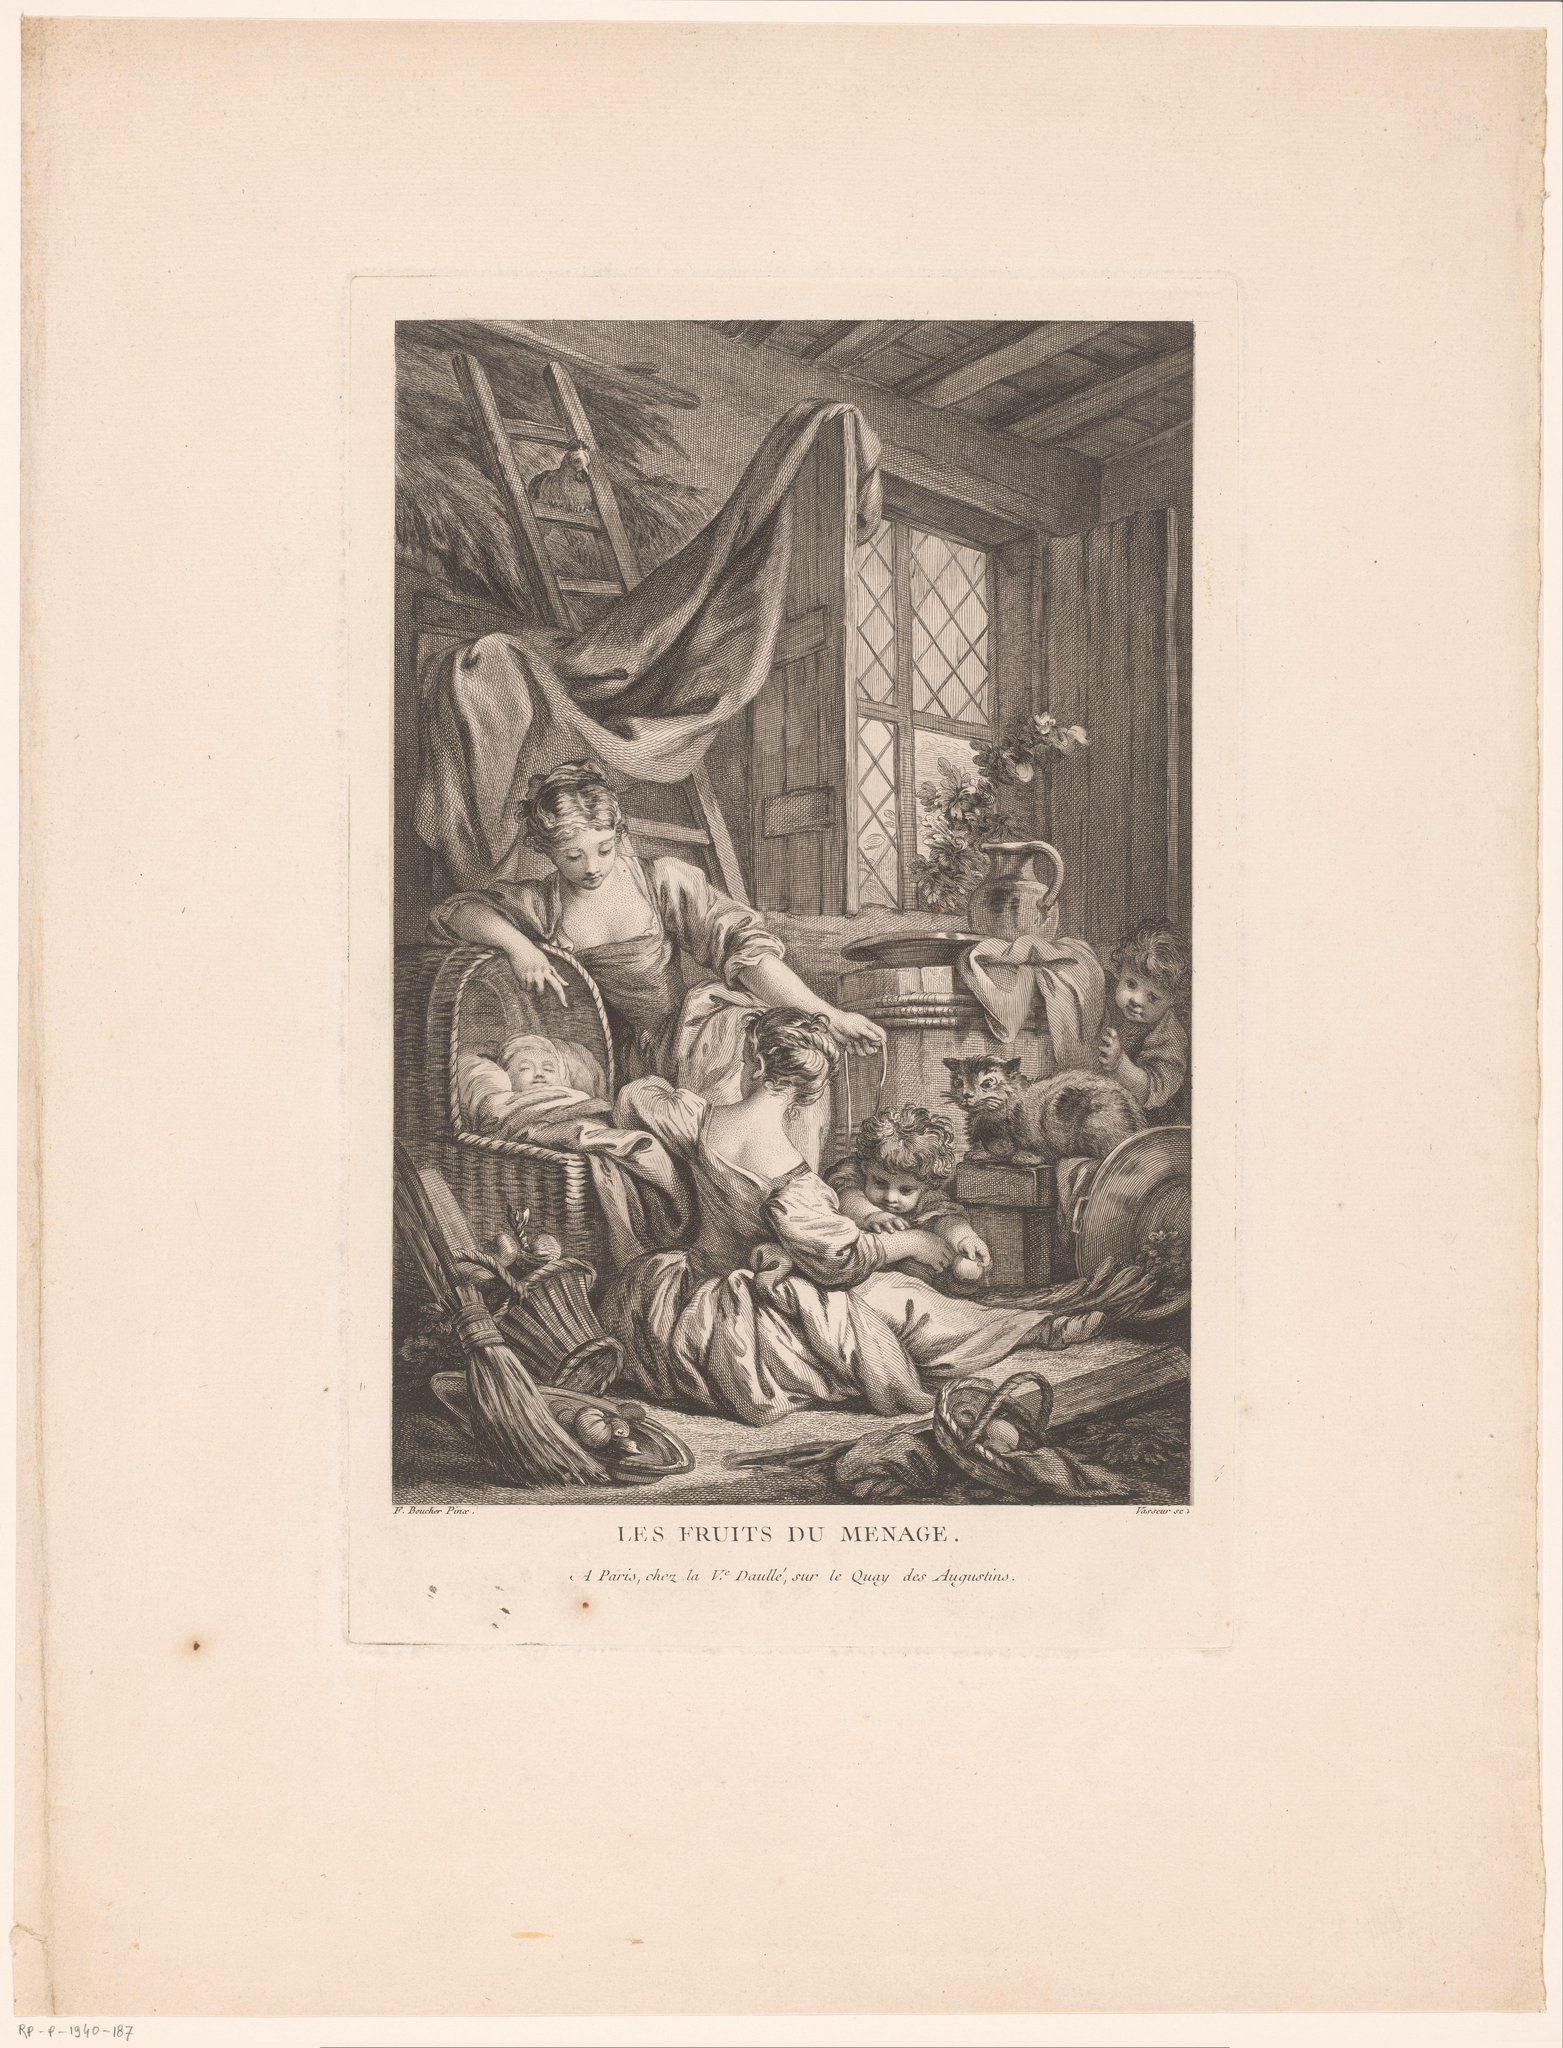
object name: print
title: Jonge moeder met kinderen en een kat in een rustiek interieur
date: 1763-1770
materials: paper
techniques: engraving, etching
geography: paris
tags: cradle, crib, mother and baby or young child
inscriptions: collector's mark: Lugt 2228